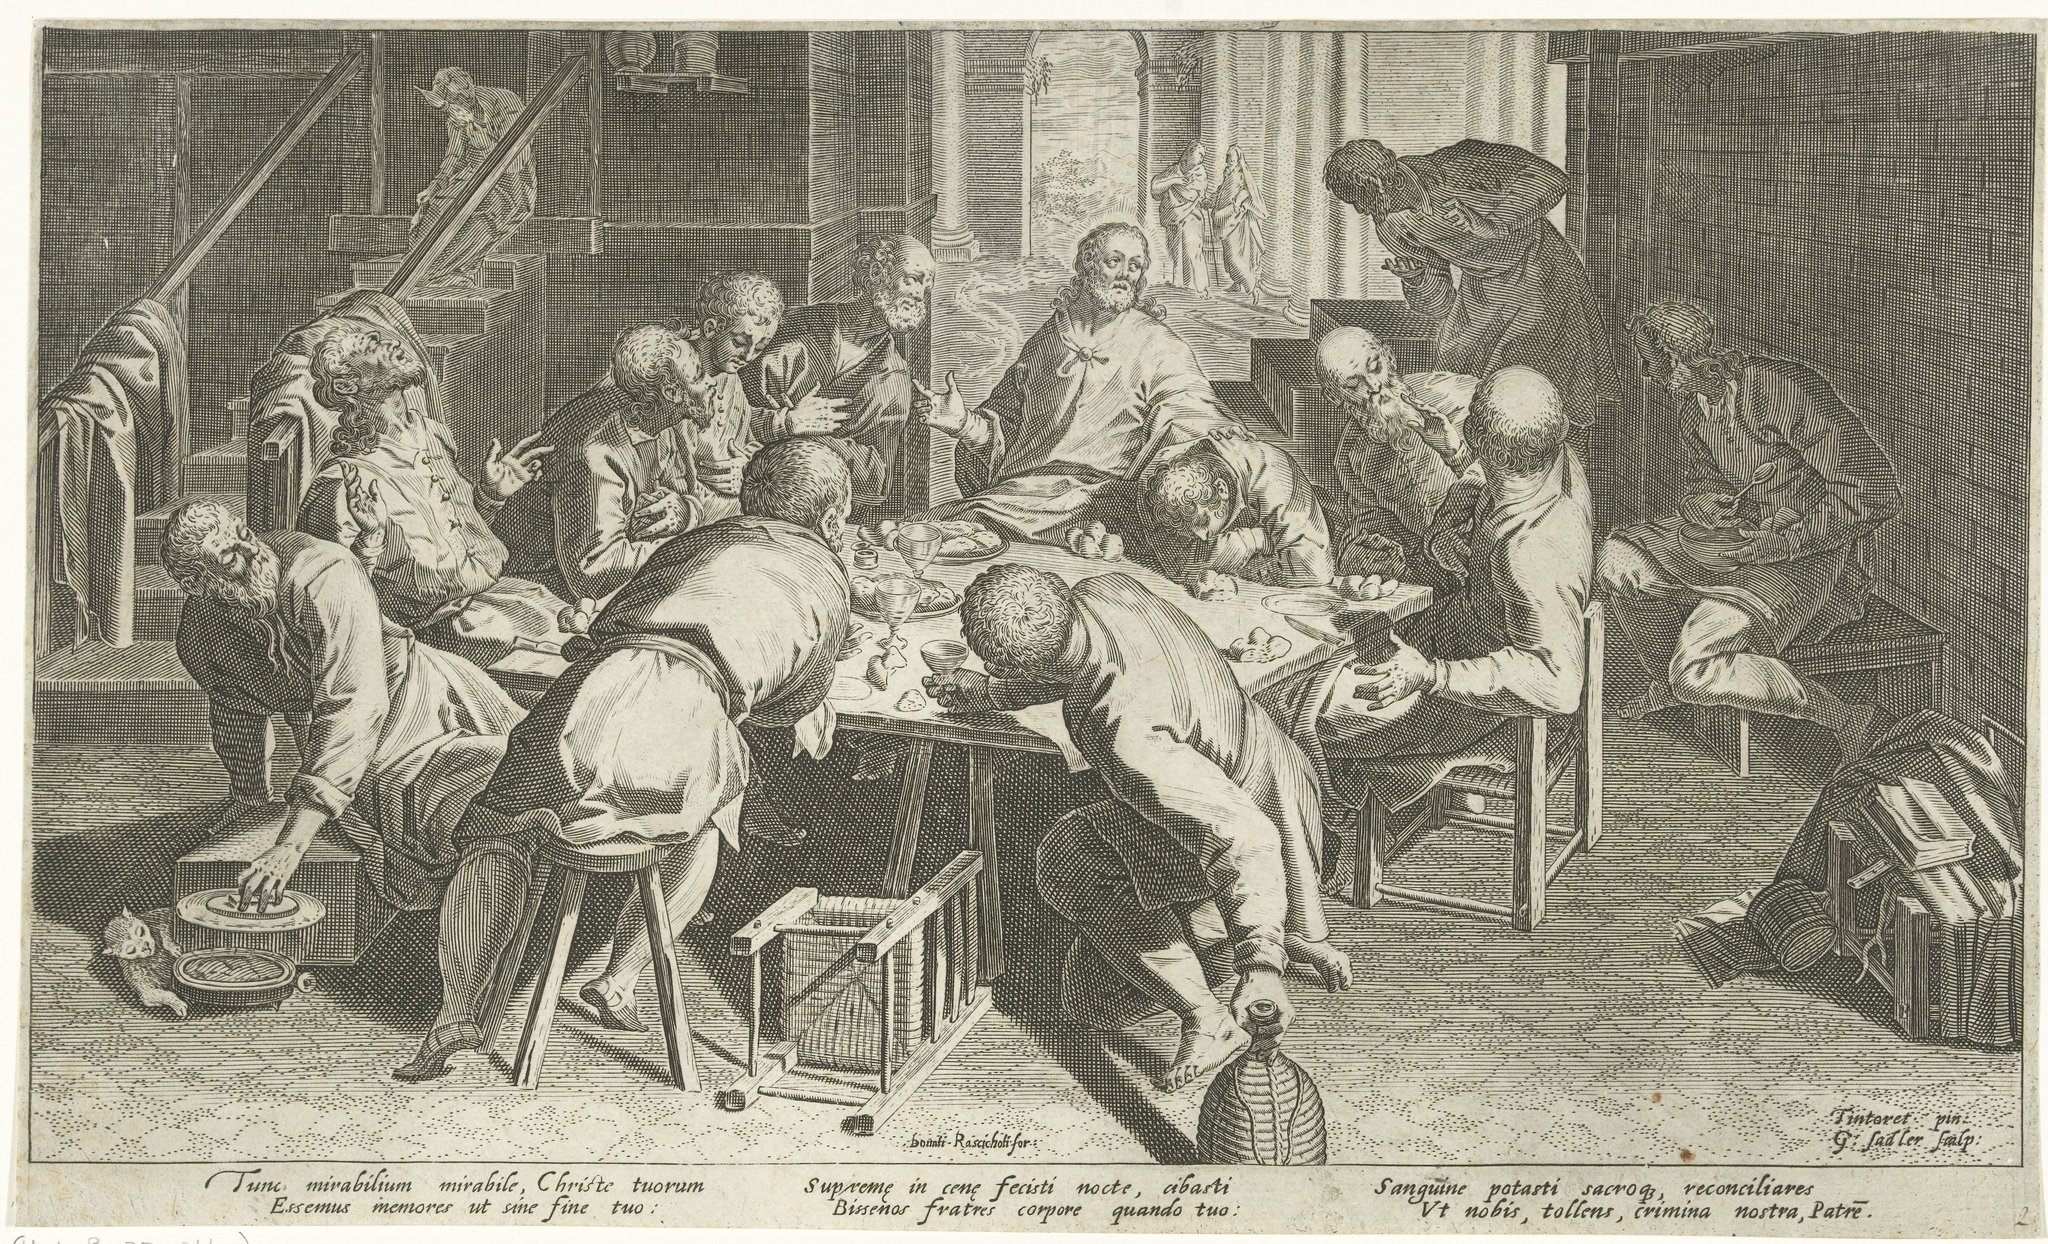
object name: print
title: Laatste avondmaal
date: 1580-1629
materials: paper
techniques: engraving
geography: italy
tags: last supper (in general) (matthew 26:21-35; mark 14:18-31; luke 22:3, 22:15-23; john 13:21-38)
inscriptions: collector's mark: Lugt 11, collector's mark: Lugt 10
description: Christus zit samen met zijn leerlingen aan een rechthoekige tafel. Er wordt gegeten en gedronken. De prent heeft een Latijns onderschrift over dit Bijbelverhaal.